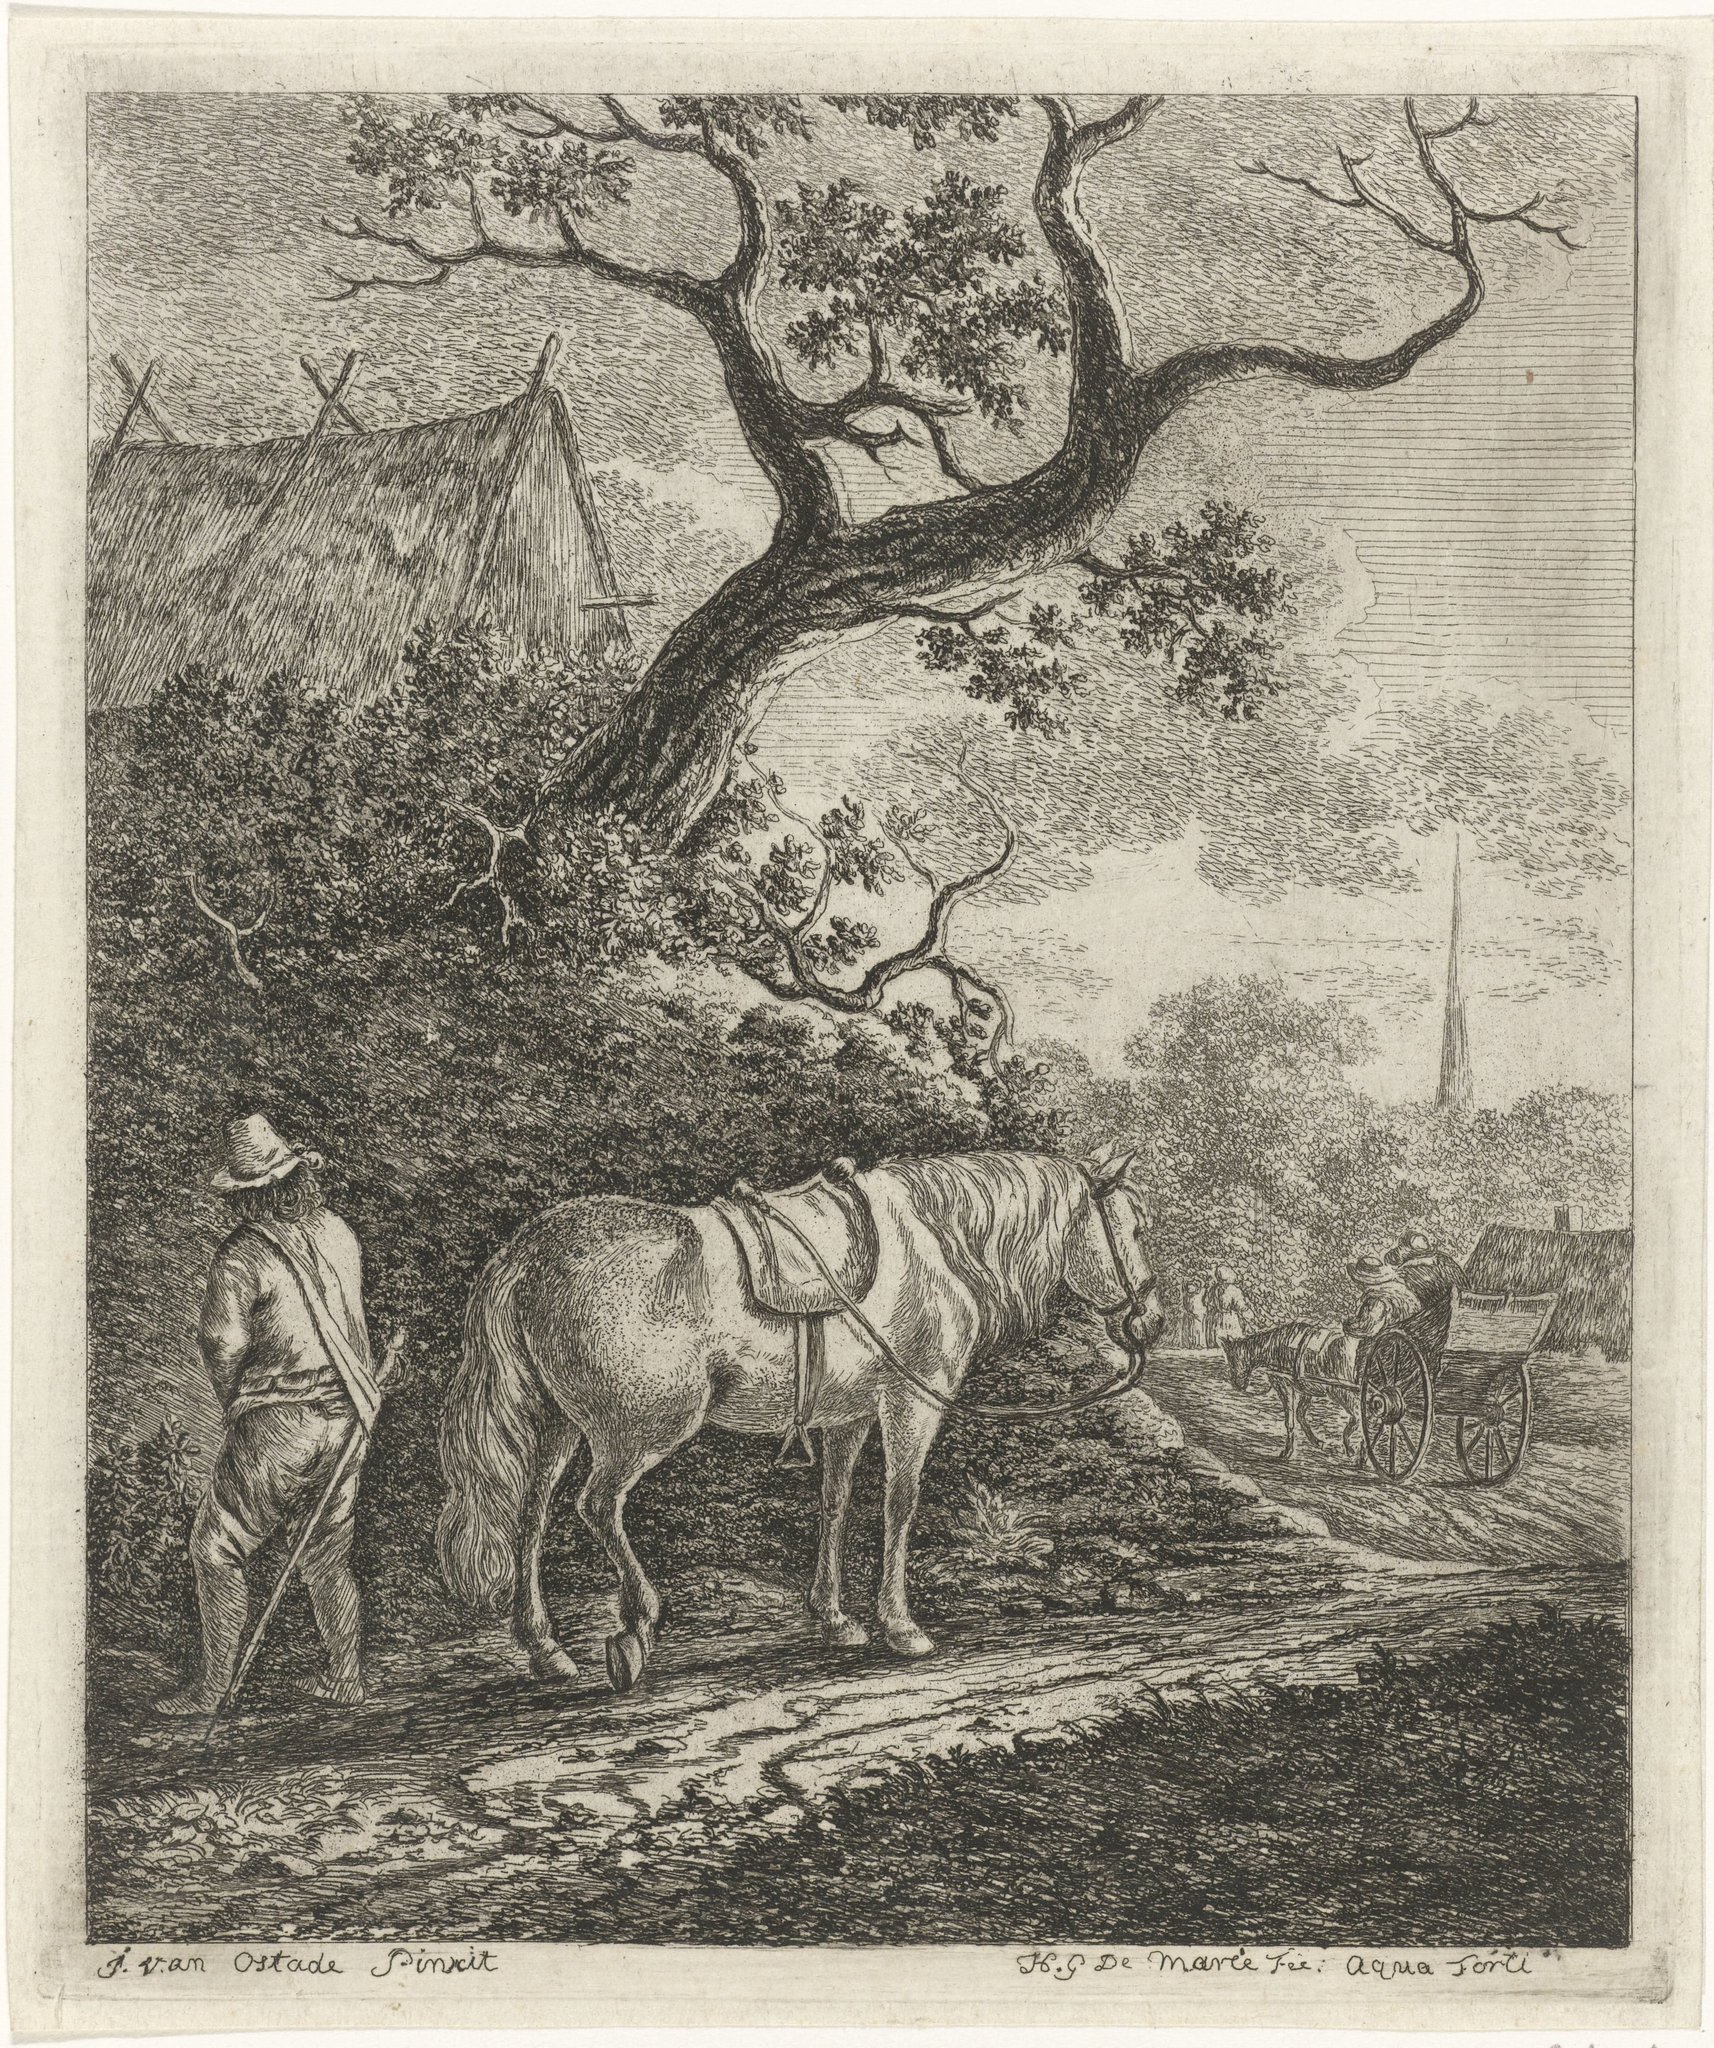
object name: print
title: Paard op landweg met waterende man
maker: isaac van ostade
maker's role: draughtsman, painter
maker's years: 1621-1649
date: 1752-1783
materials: paper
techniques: etching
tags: horse, urination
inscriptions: collector's mark: Lugt 2228